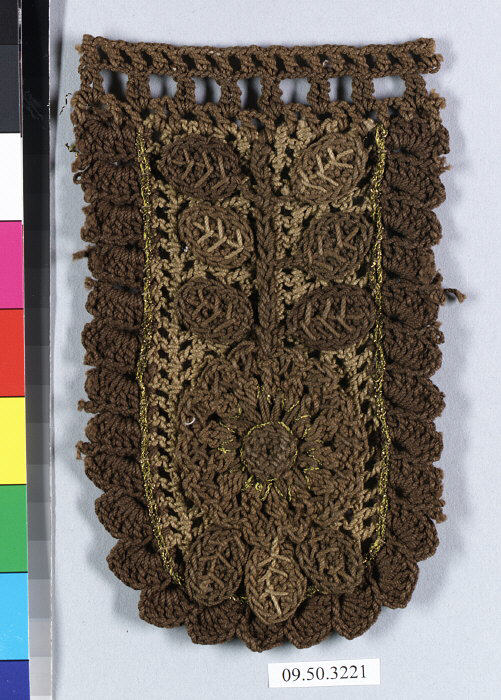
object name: sample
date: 1801-1900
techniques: crochet